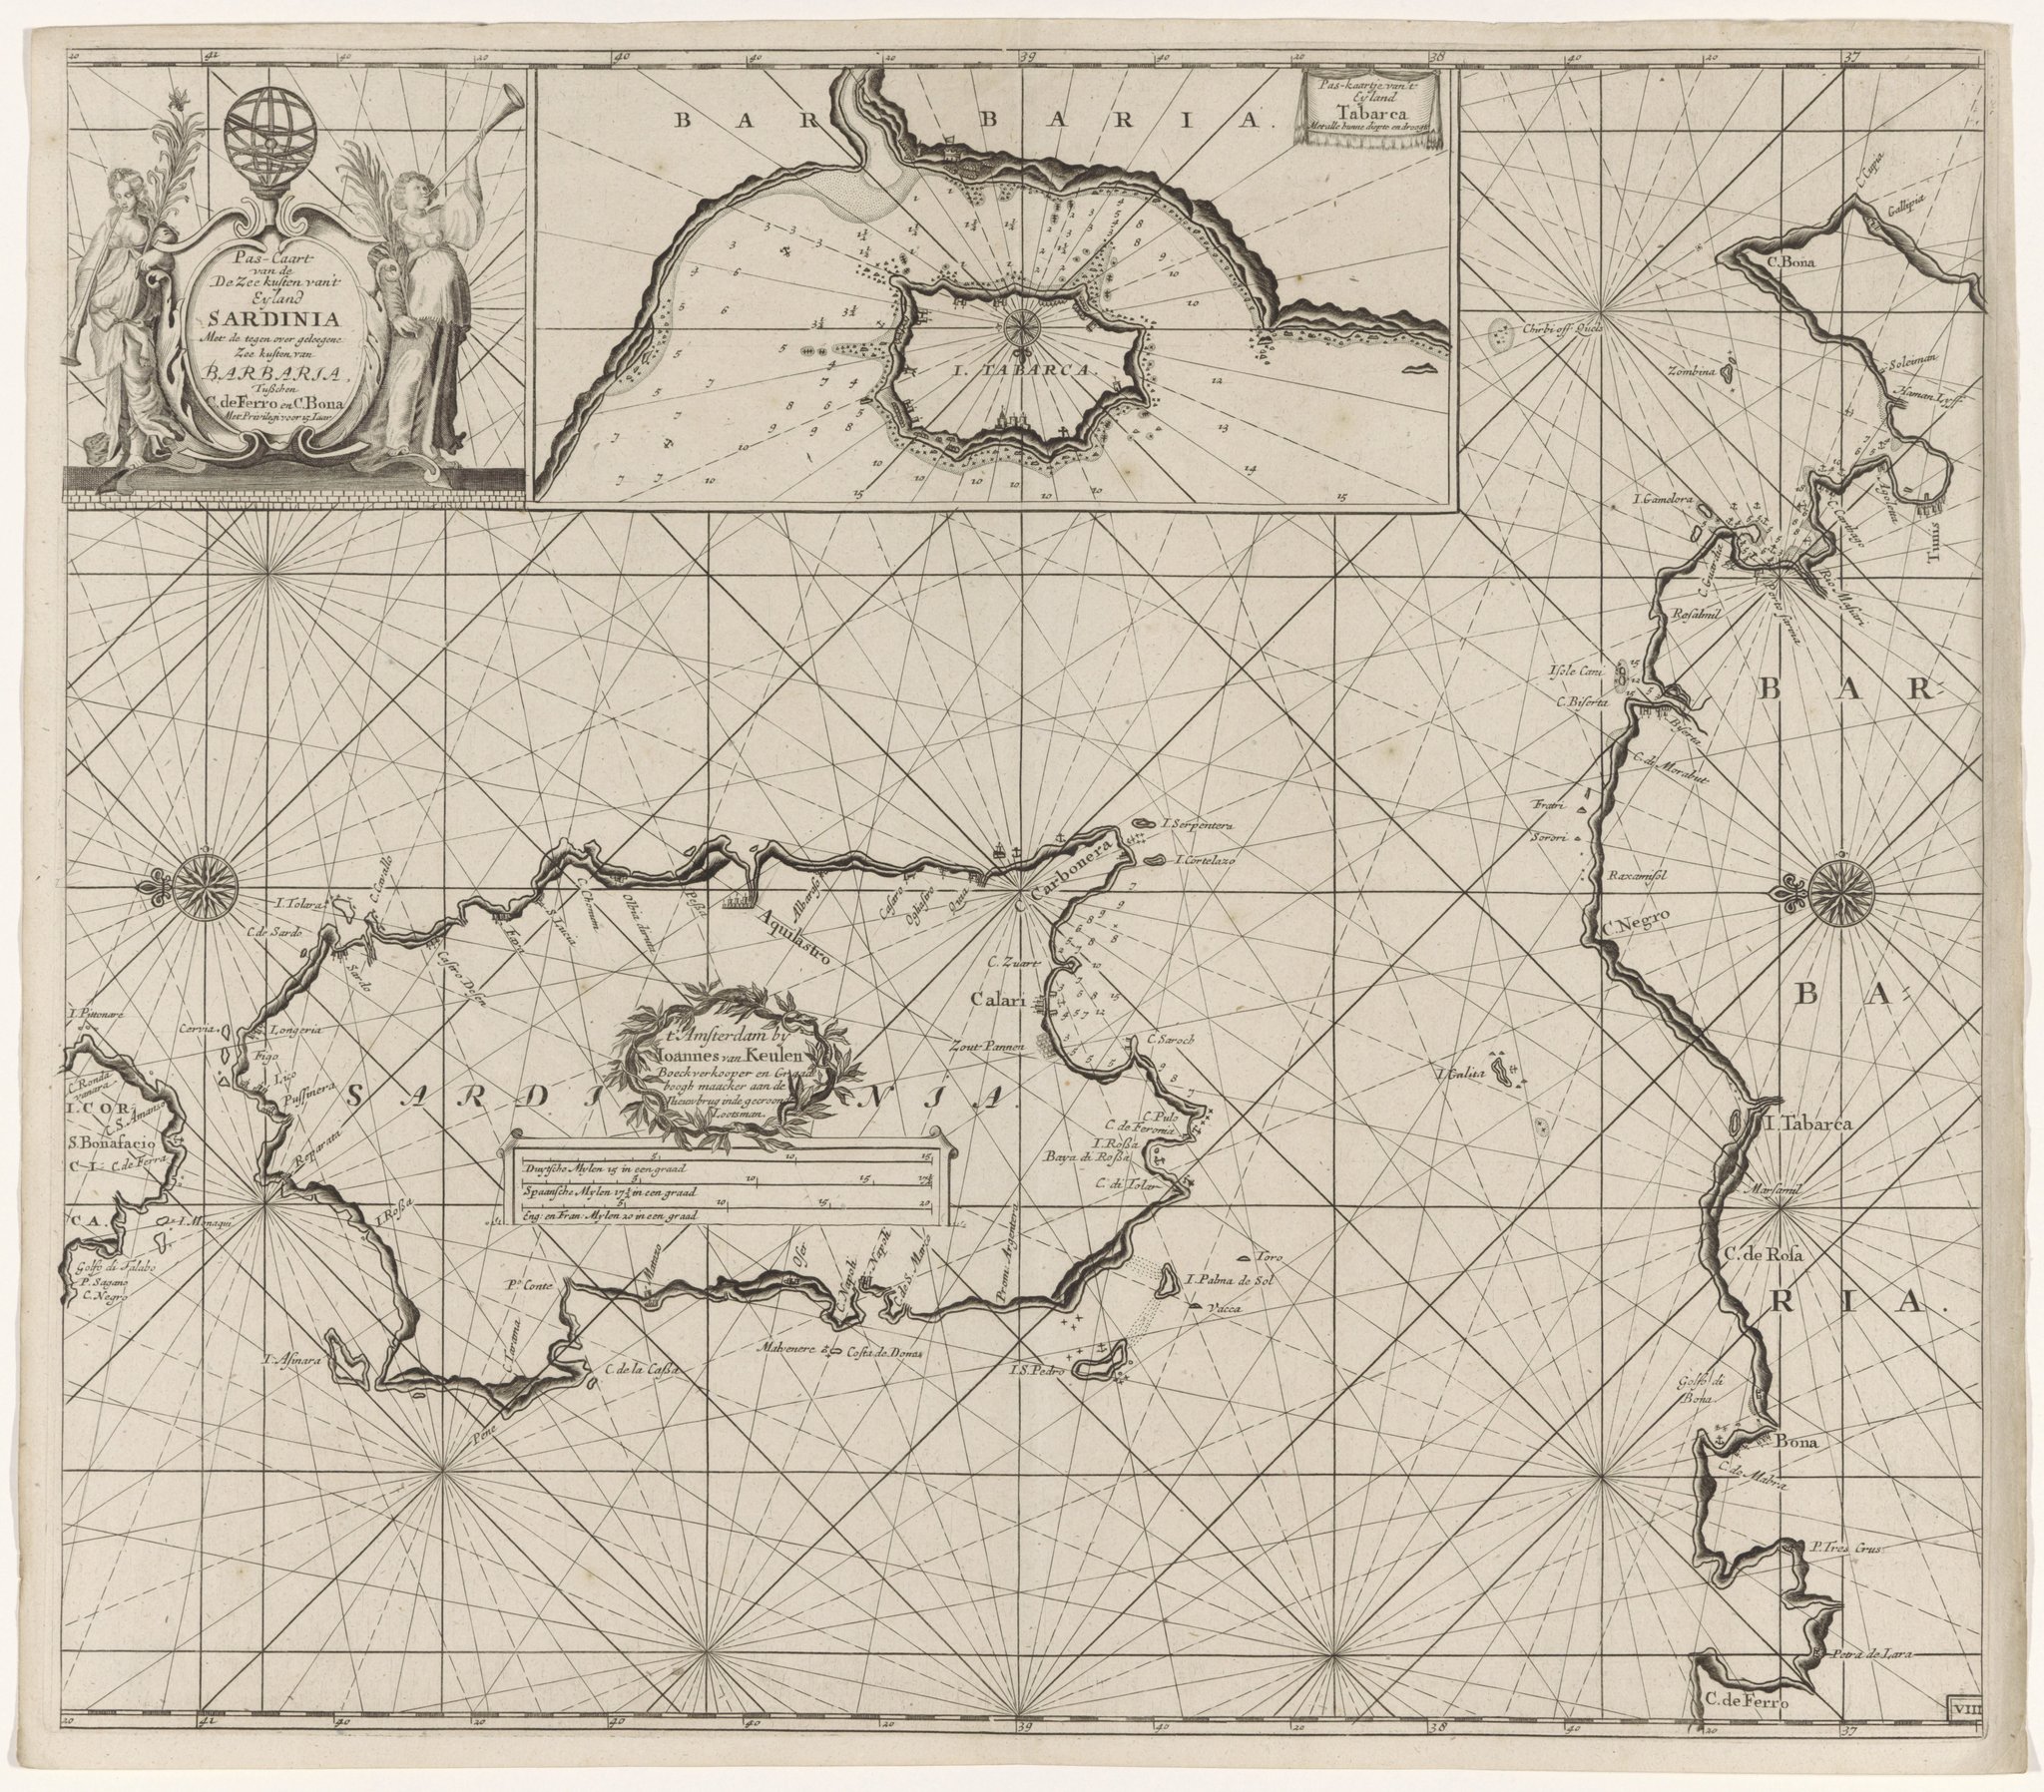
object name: print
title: Zeekaart van het eiland Sardinië en een deel van de kust van Noord-Afrika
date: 1682-1803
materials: paper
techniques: engraving, etching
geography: amsterdam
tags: horn, trumpet, cornet, trombone, tuba, armillary sphere, skeleton celestial globe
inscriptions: collector's mark: Lugt 2228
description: Zeekaart van het eiland Sardinië en een deel van de kust van Noord-Afrika met een inzetkaart van het eiland Tabarca, met drie kompasrozen. Linksboven de cartouche met de titel, geflankeerd door twee vrouwen met een palmtak en een bazuin. In het centrum het adres van de uitgever en de schaalverdeling, weergegeven in Duitse, Spaanse en Engelse of Franse mijlen (schaal: c. 1:900.000).